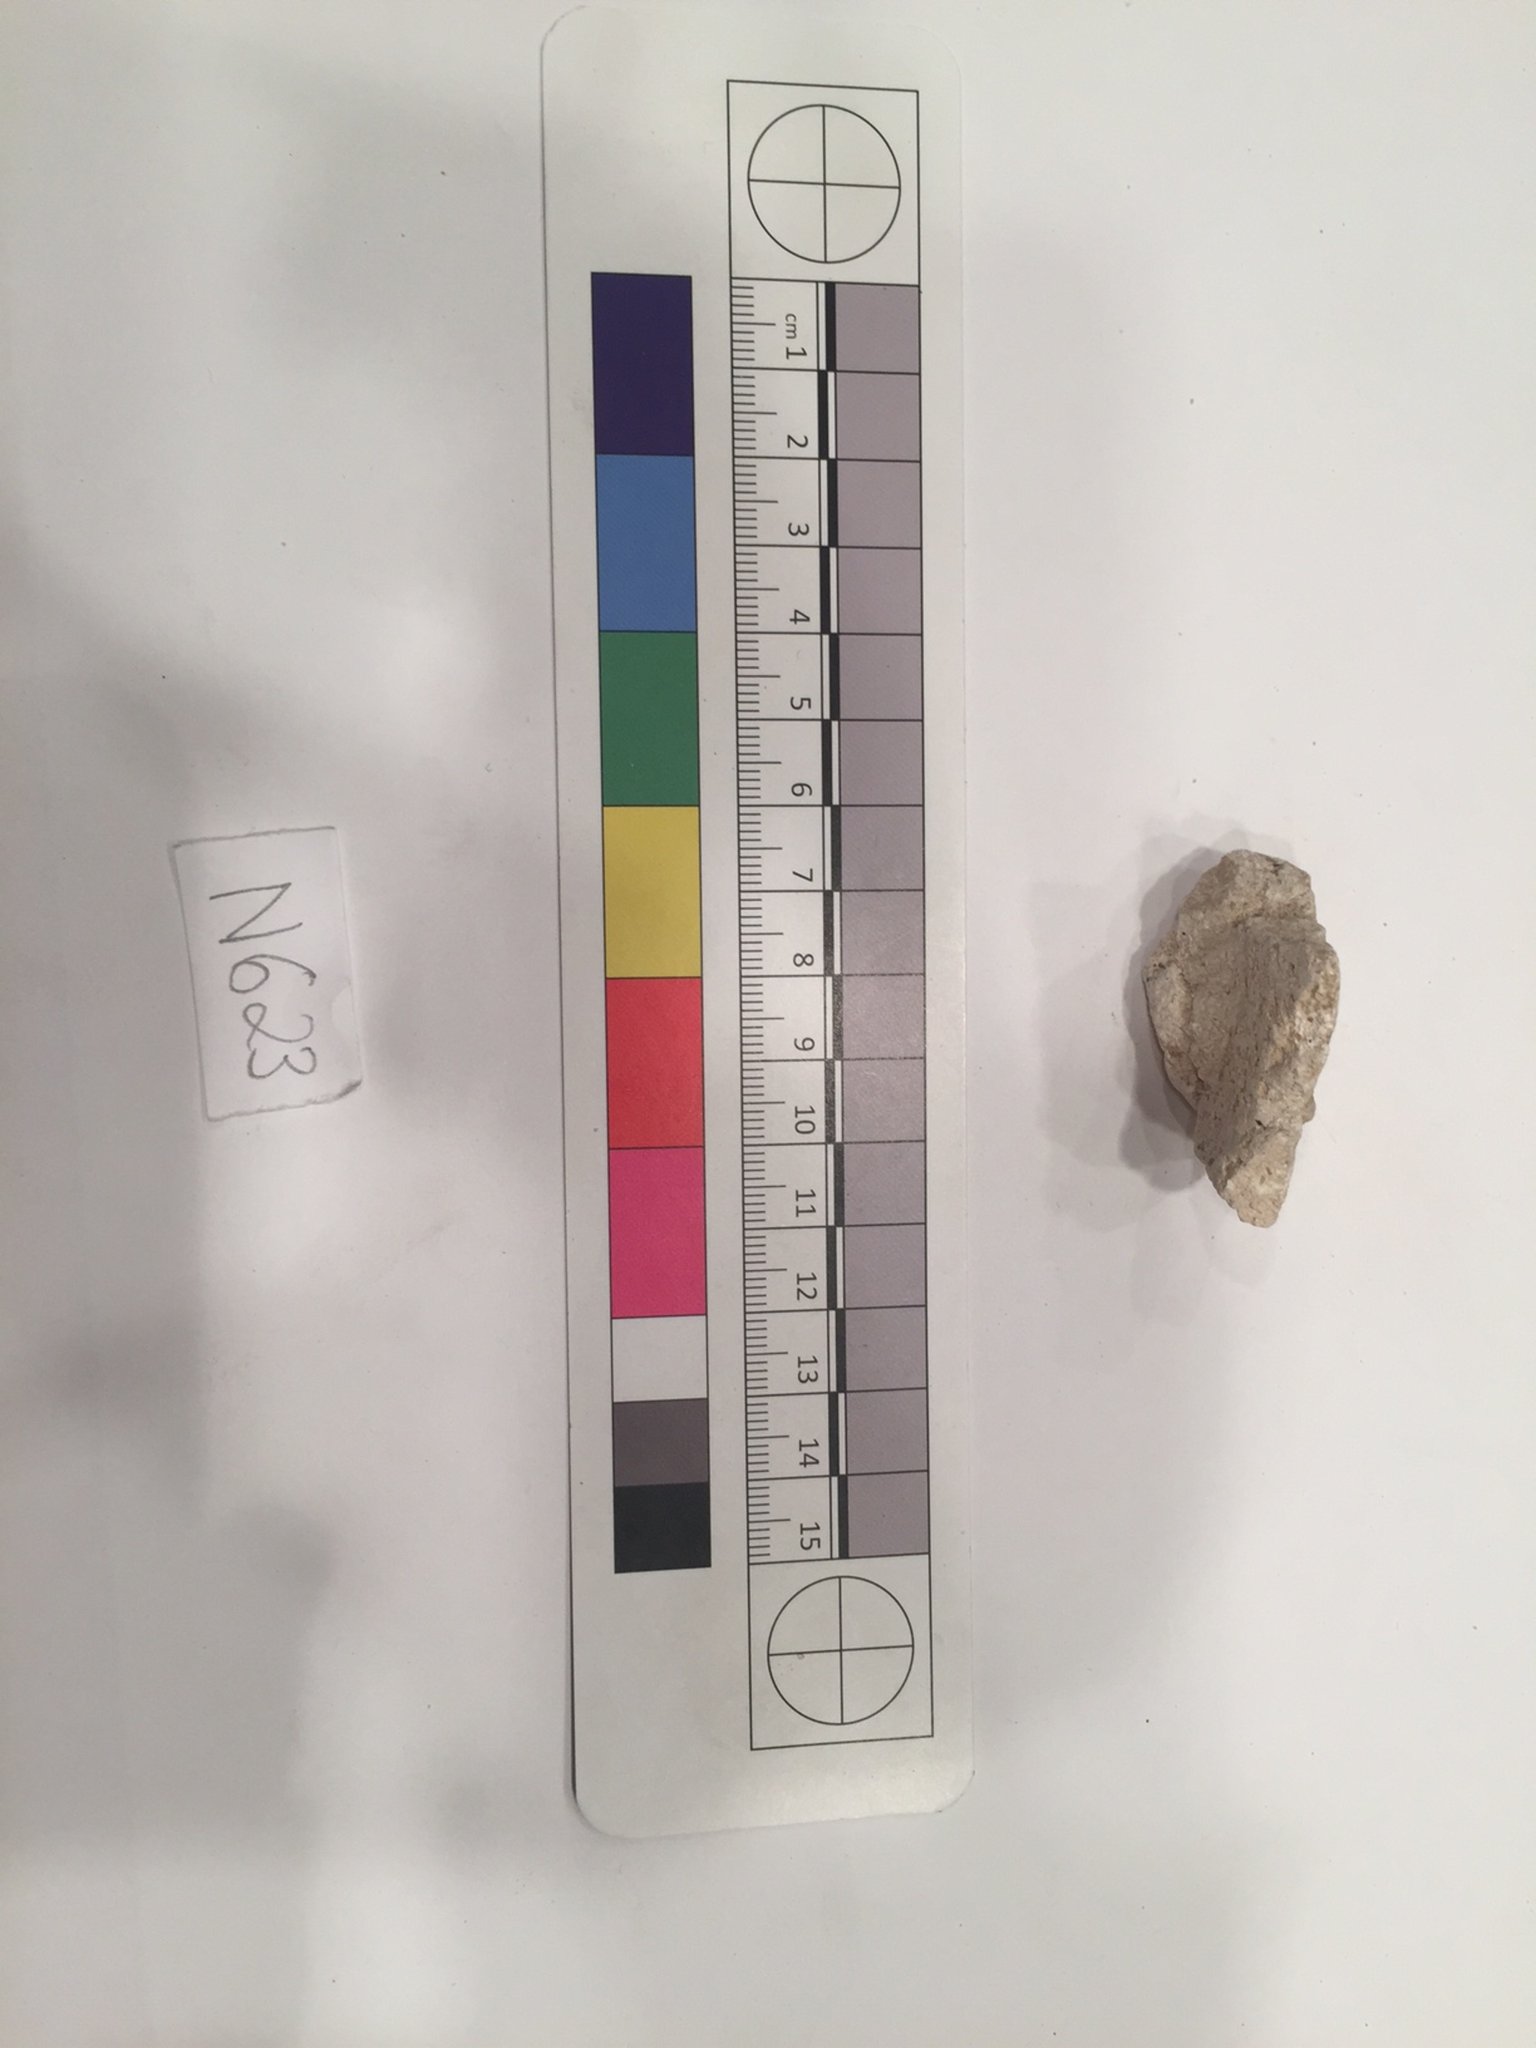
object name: fragment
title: Stucco Fragment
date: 701-1200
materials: plaster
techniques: carving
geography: iran